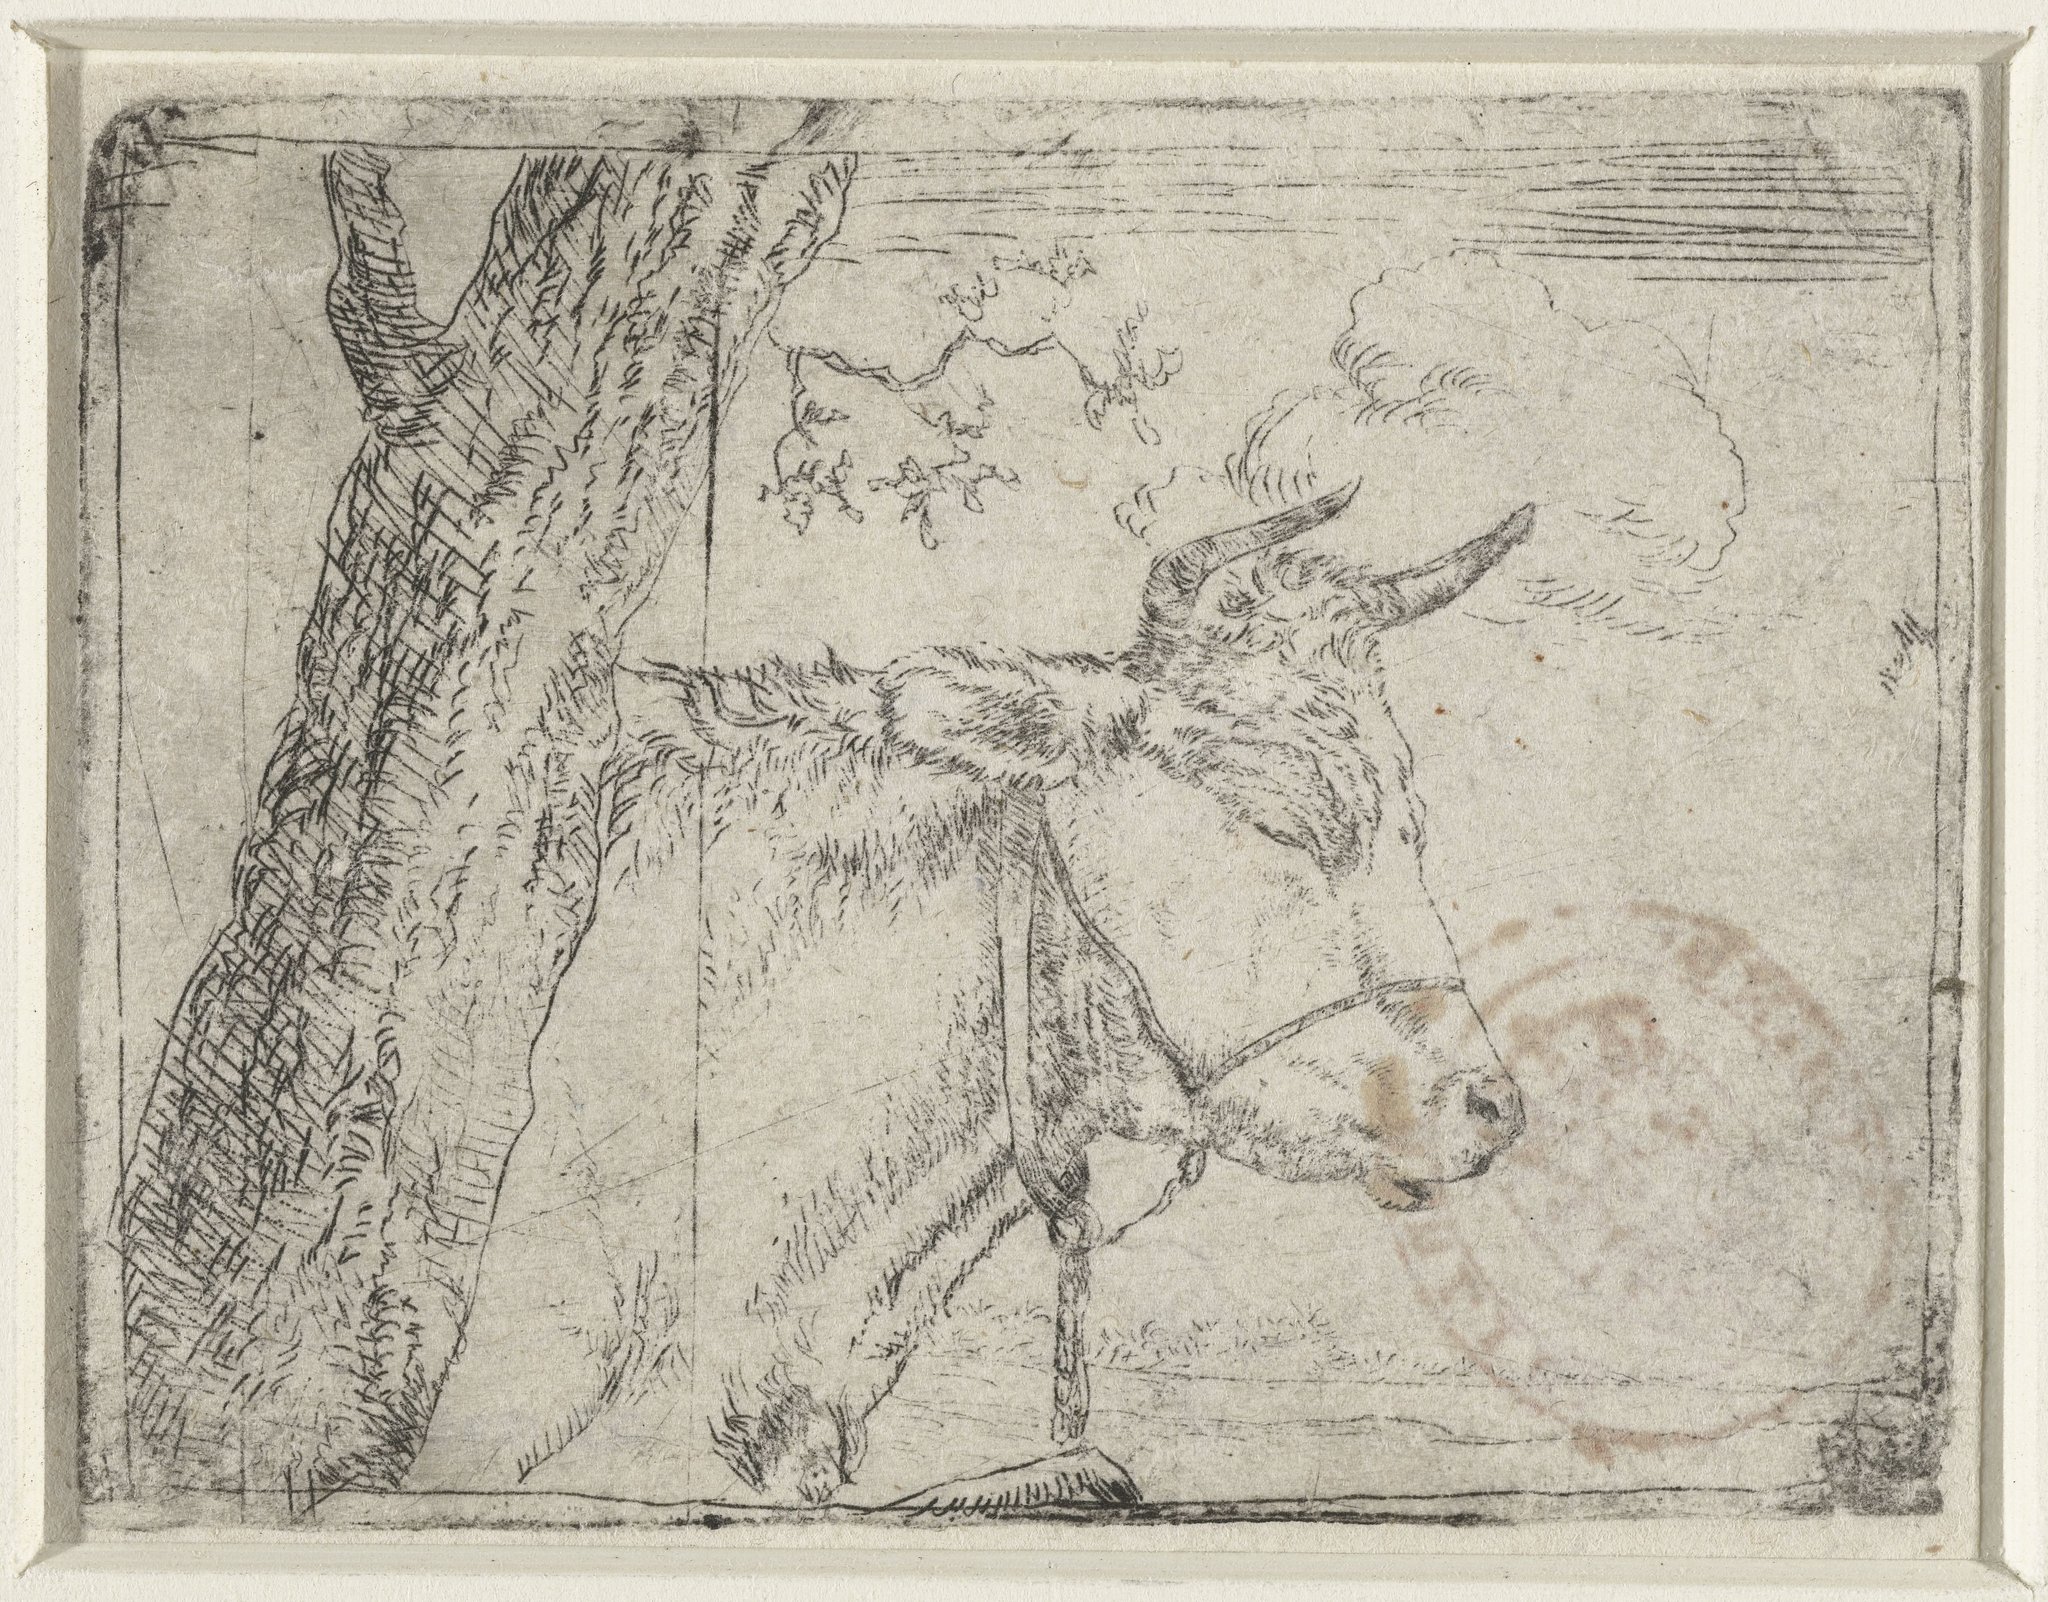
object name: print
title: Kop van een koe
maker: paulus potter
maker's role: draughtsman, painter, print maker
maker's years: 1625-1654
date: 1635-1654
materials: paper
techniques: etching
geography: netherlands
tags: cow, animals (+ head of an animal)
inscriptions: collector's mark: Lugt 240